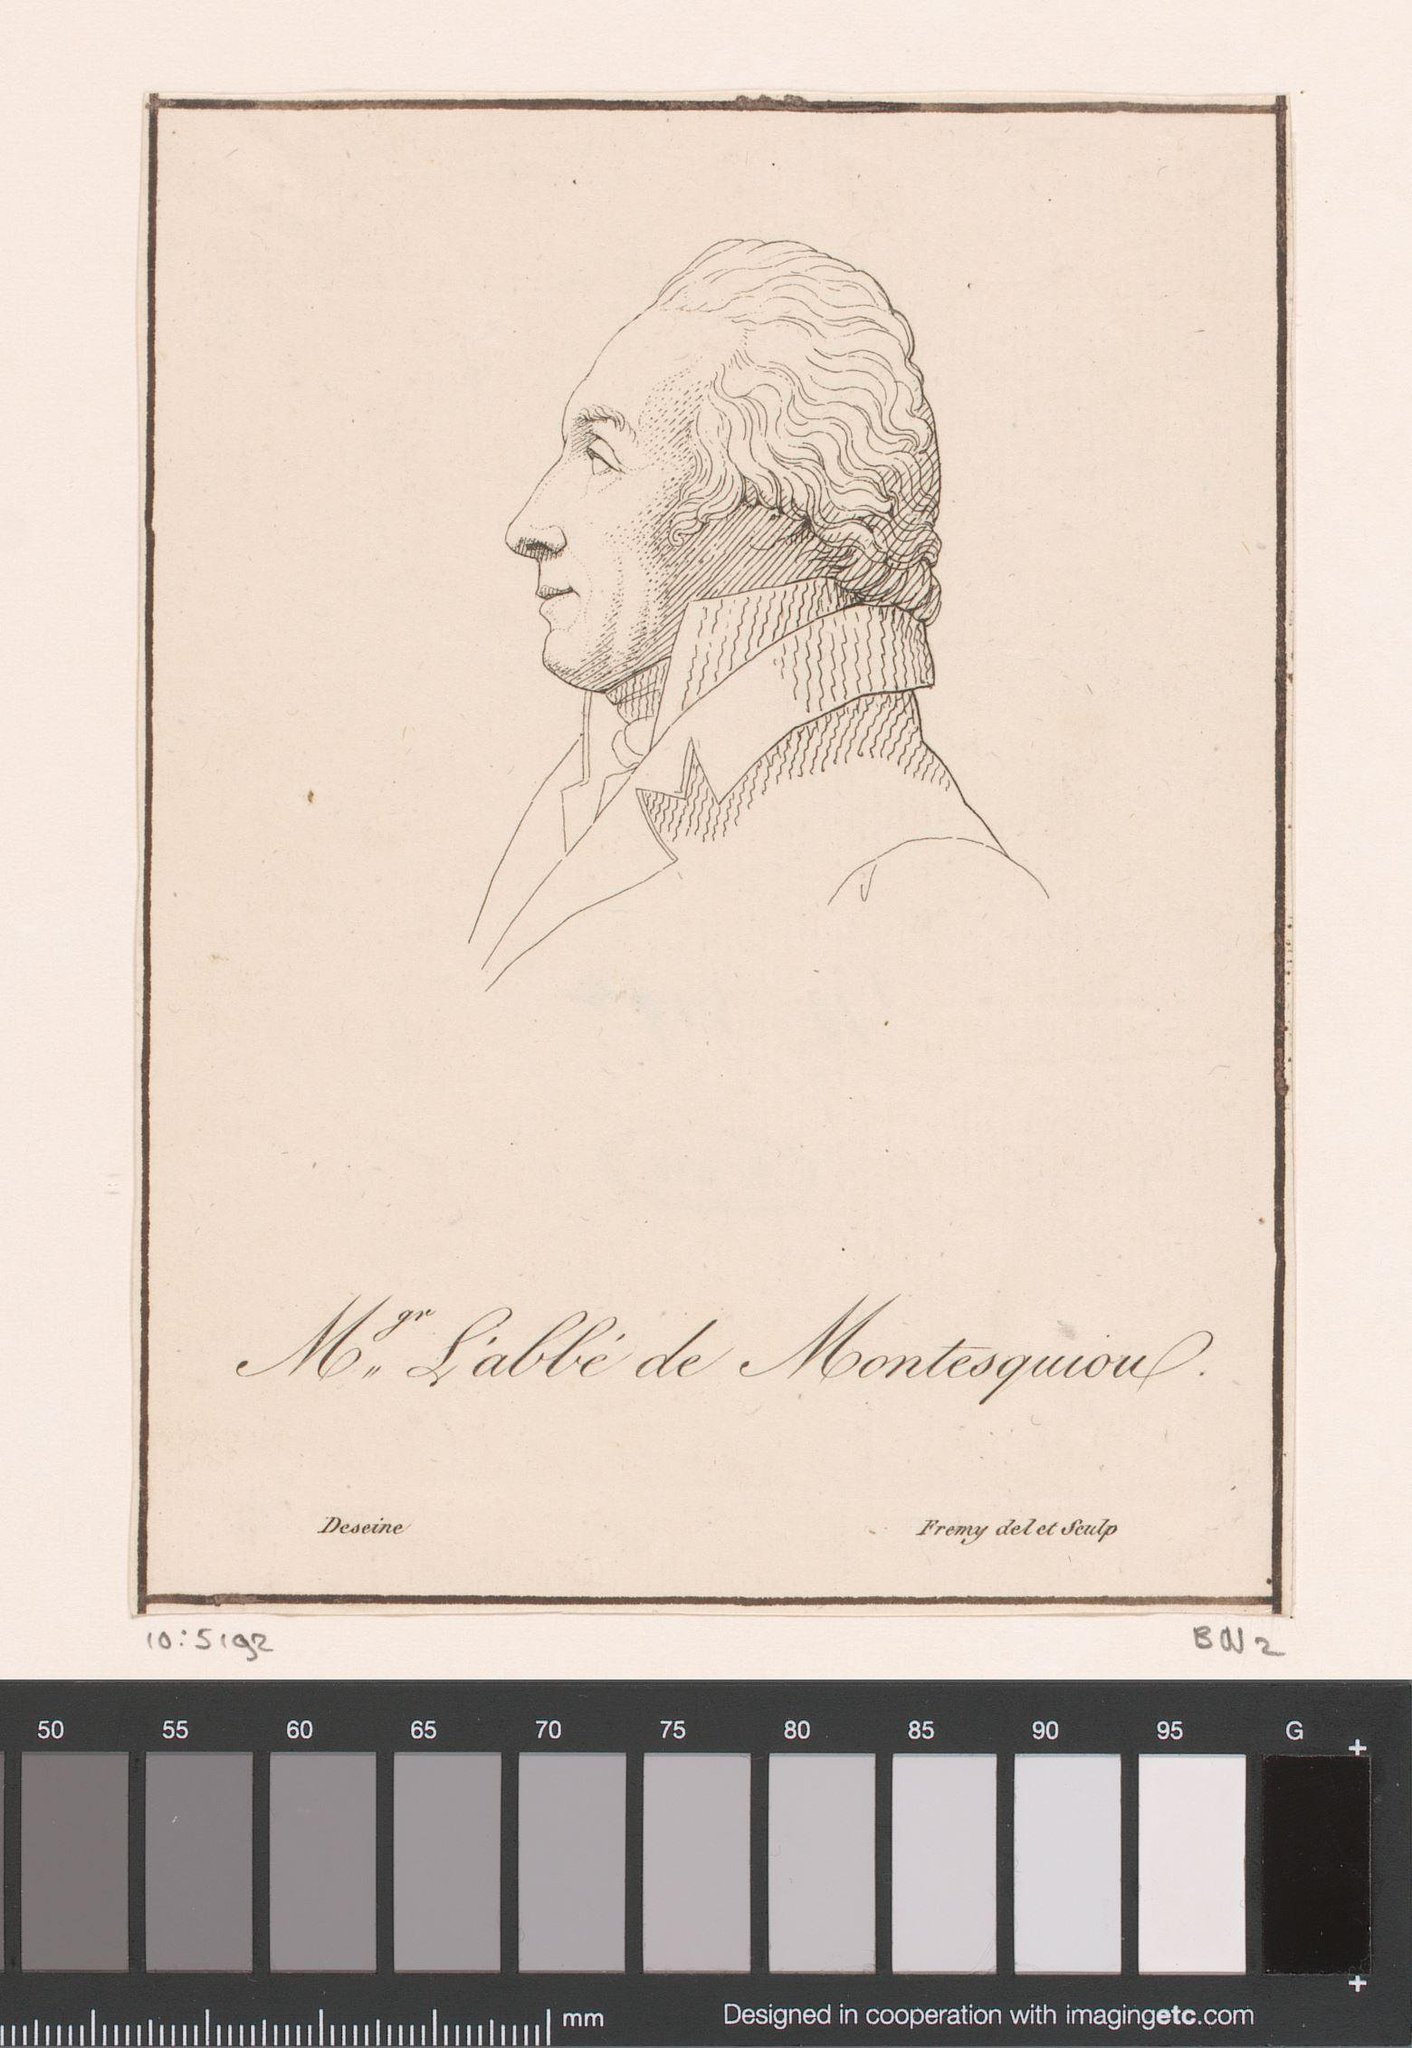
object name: book illustration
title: Portret van François-Xavier-Marc-Antoine de Montesquiou-Fézensac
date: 1815-1817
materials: paper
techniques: etching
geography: france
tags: politician, archbishop, bishop, etc. (roman catholic), historical persons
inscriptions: collector's mark: Lugt 2228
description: Prent uit: Frémy, Jacques Noël Marie. Croquis de portraits des personnages remarquables dans tous les genres, dessinés et gravés. Parijs: Jacques Noël Marie Frémy, 1815-1817.